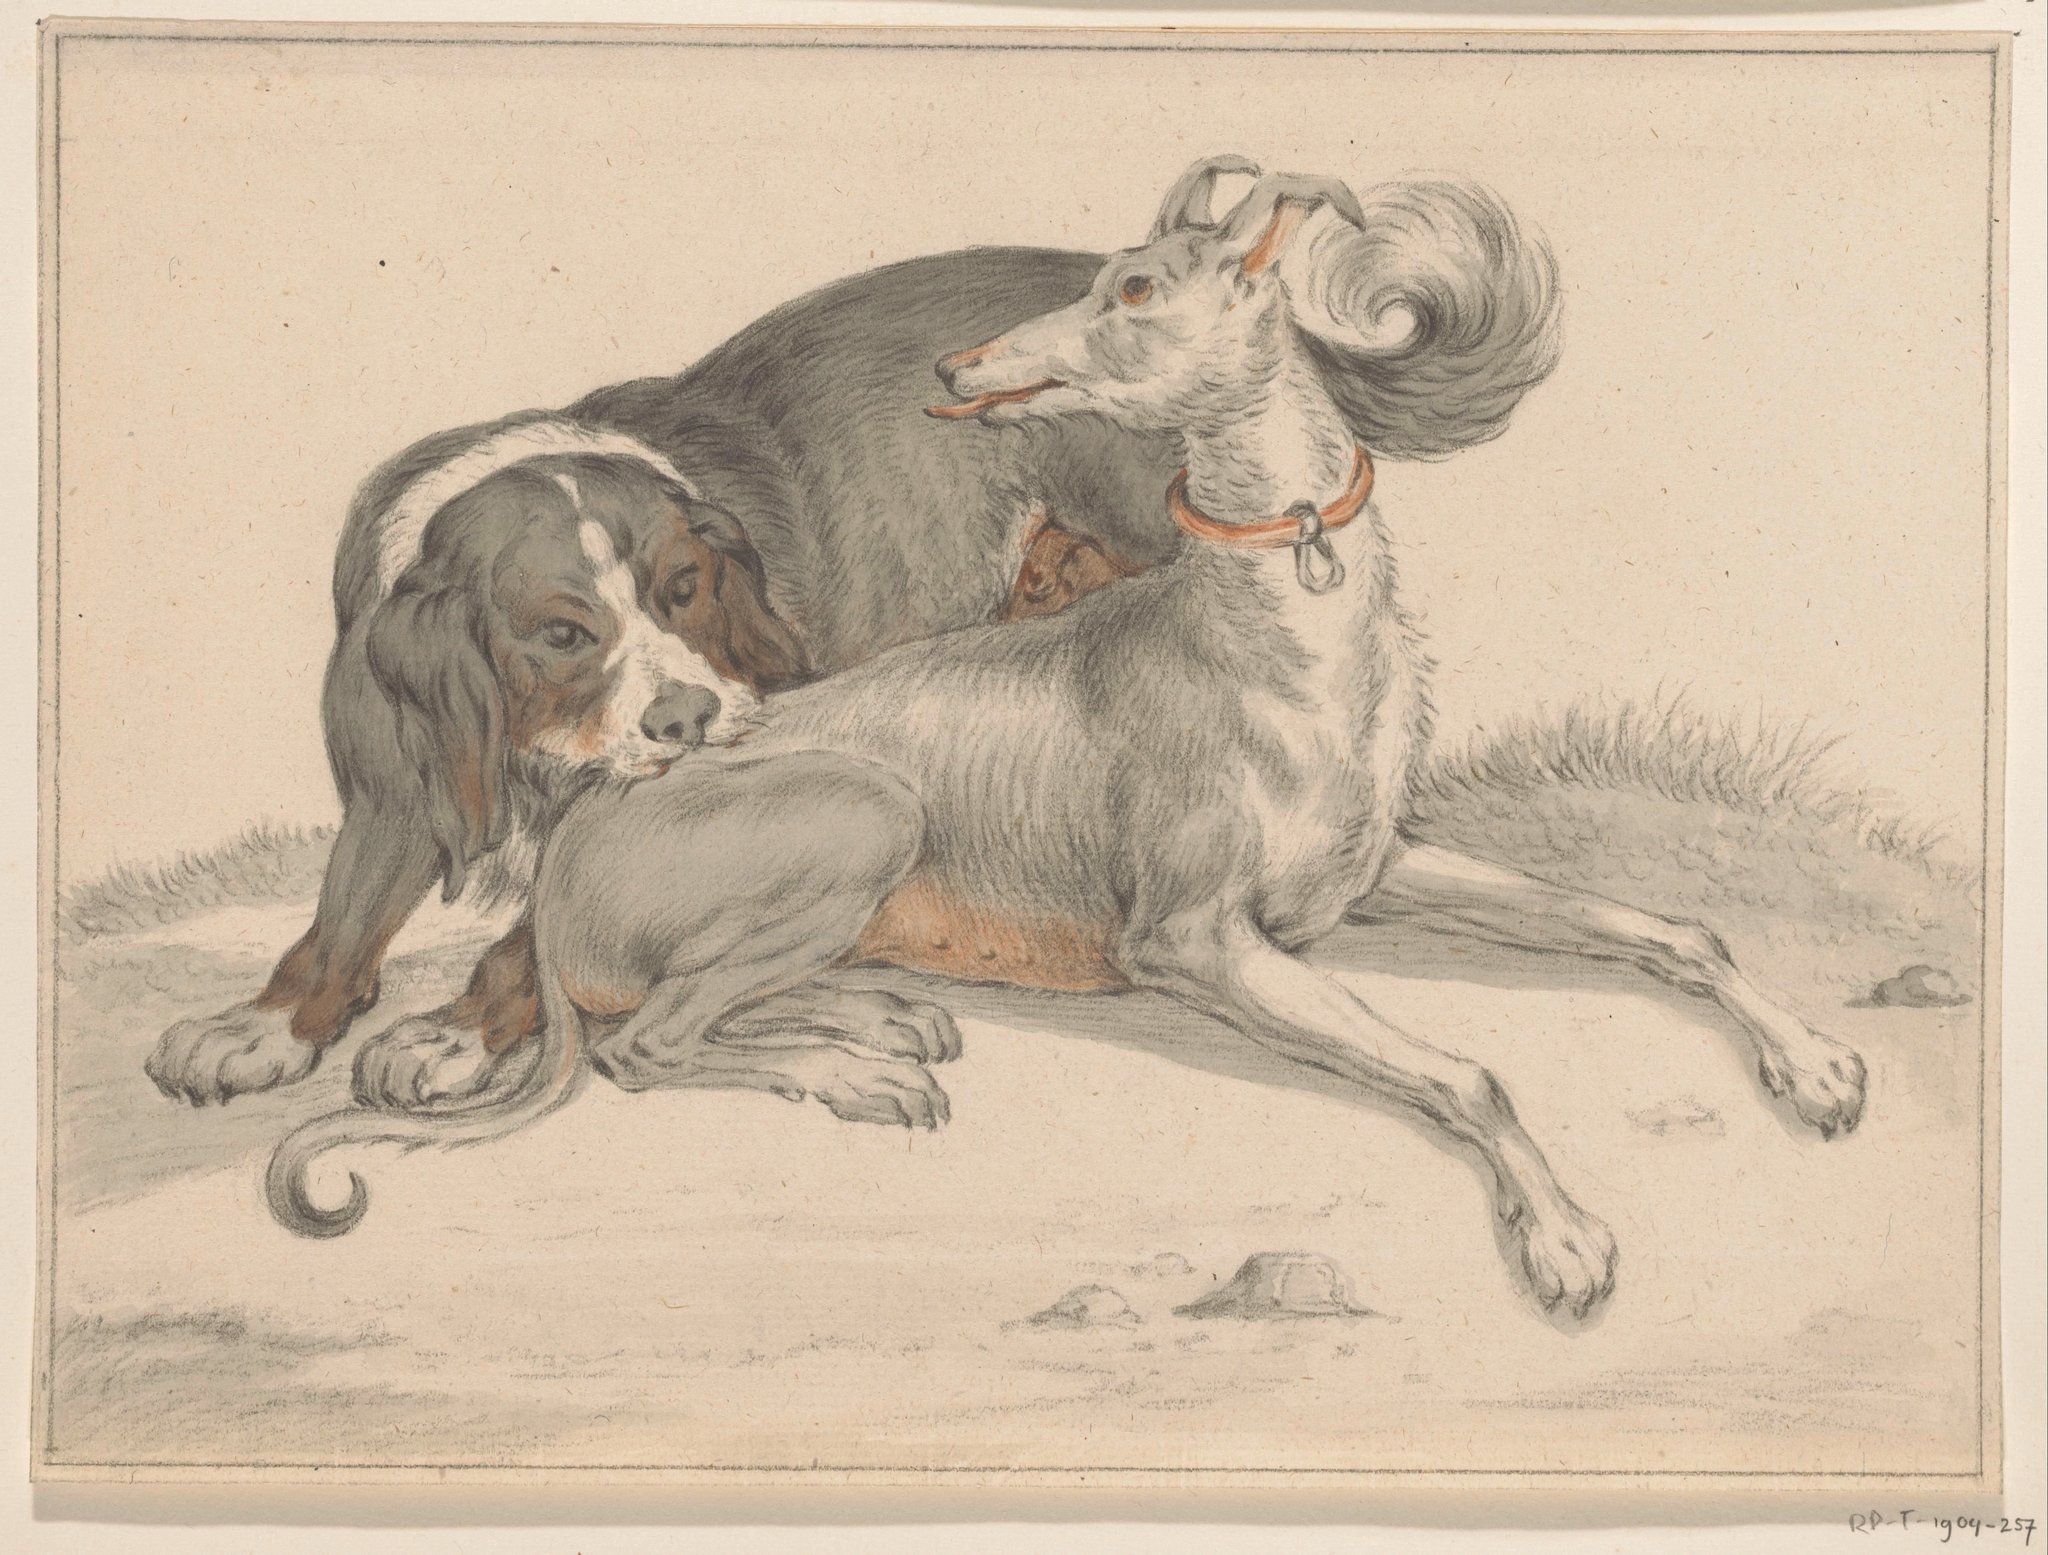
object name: drawing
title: Een hond bijt een andere zittende hond in de rug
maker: jean bernard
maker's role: draughtsman, print maker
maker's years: 1765-1833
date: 1775-1833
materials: chalk, paper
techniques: brush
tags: dog